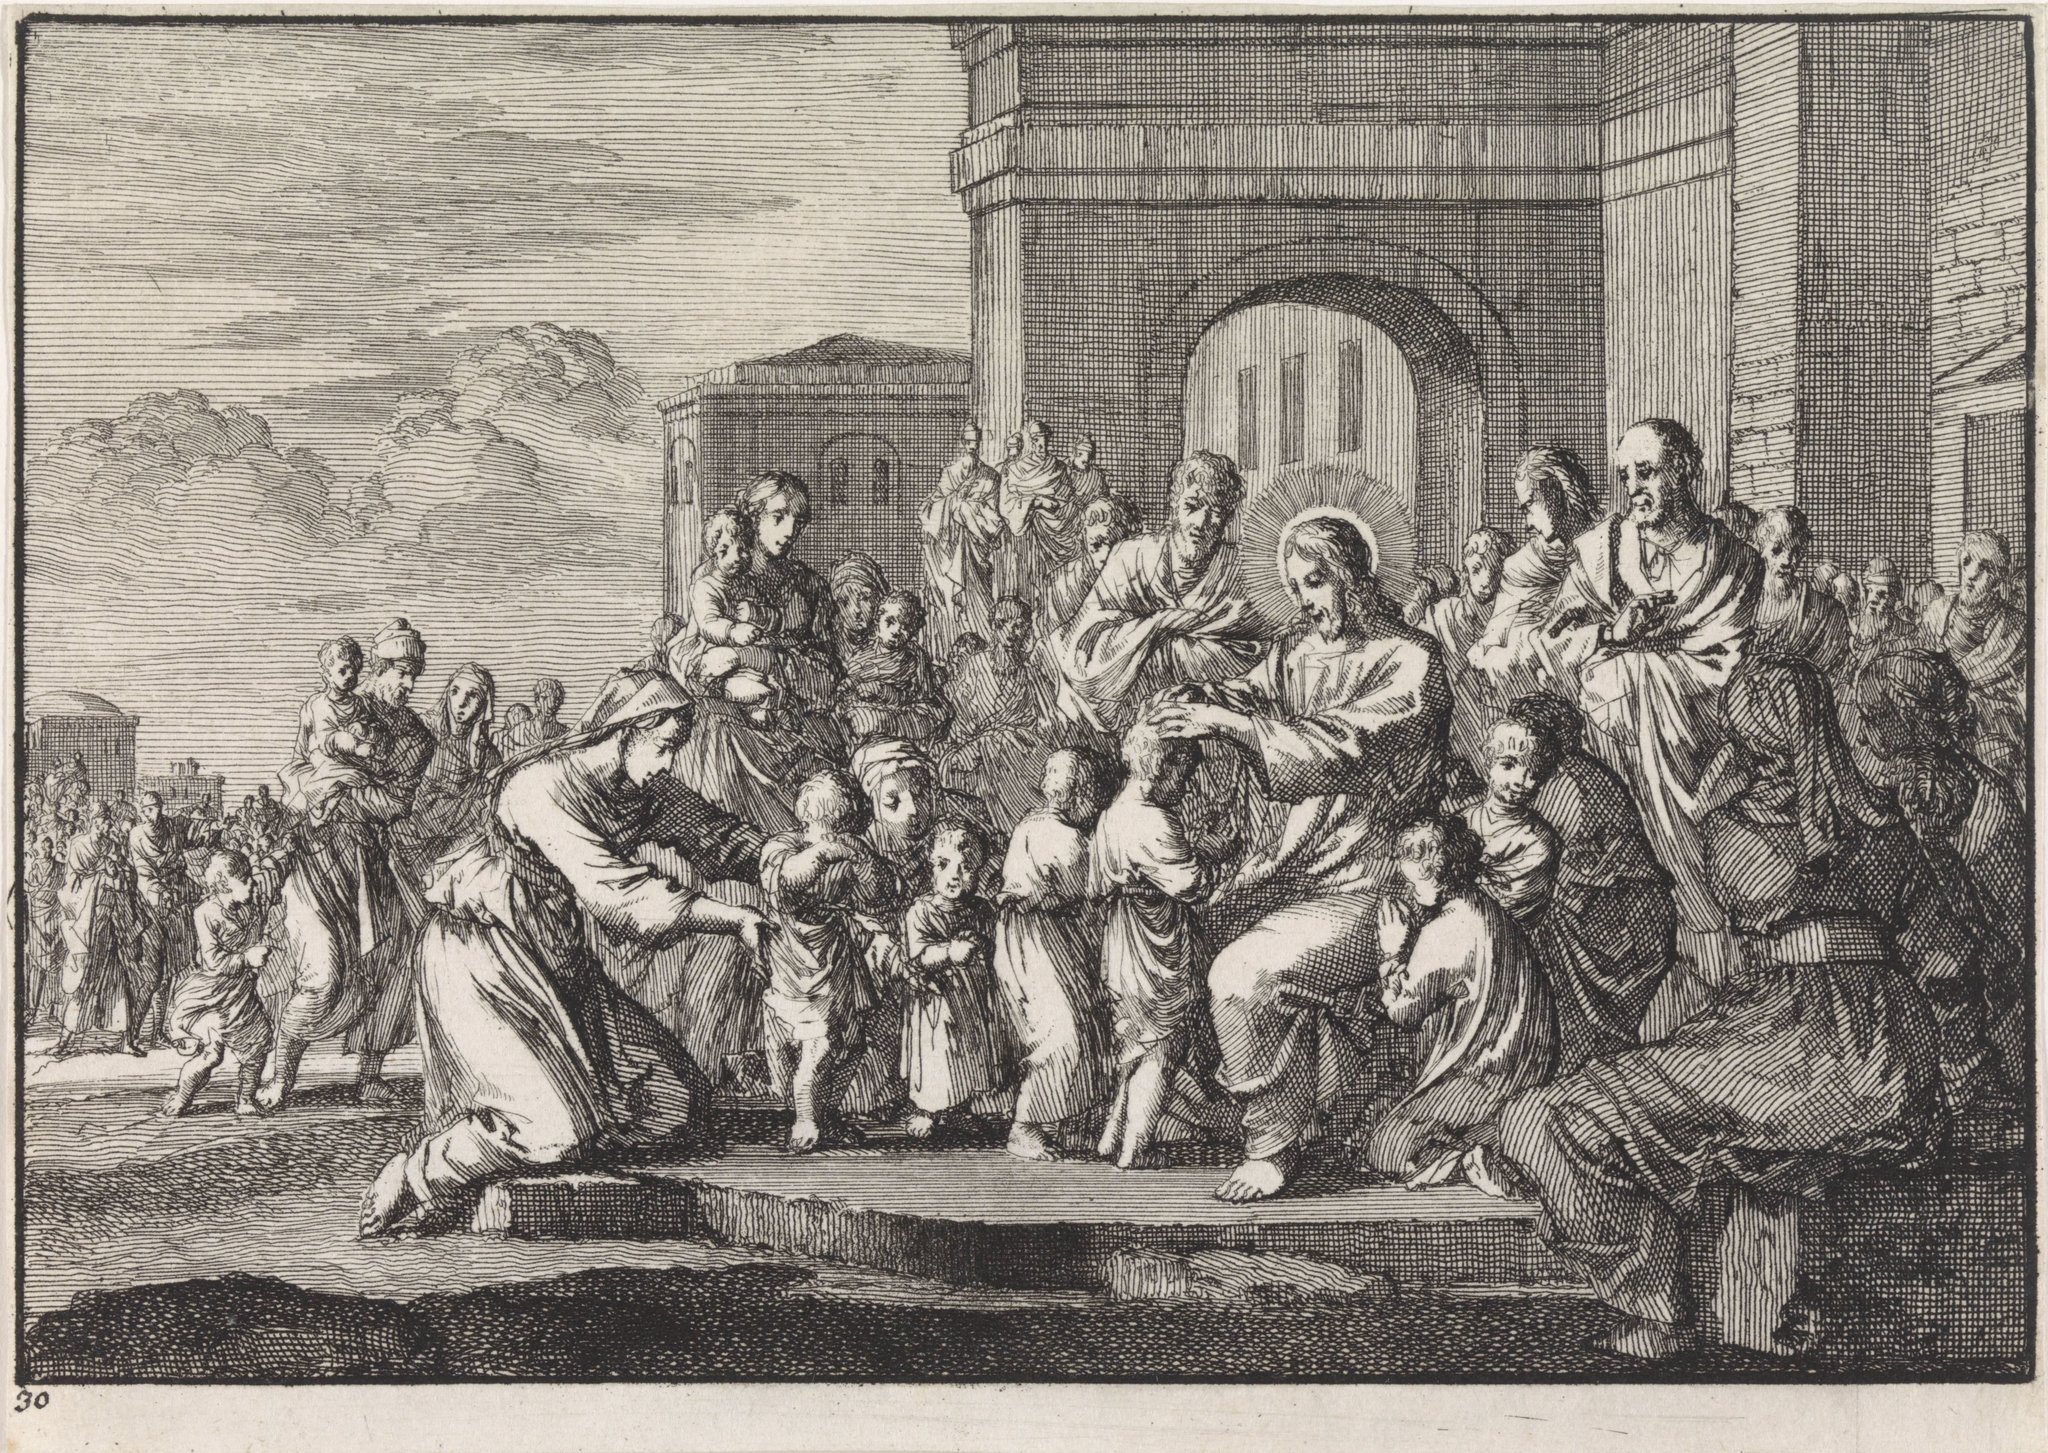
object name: print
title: Christus zegent de kinderen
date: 1703-1713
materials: paper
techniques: etching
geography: haarlem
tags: christ blessing children brought by their mothers, usually with some disciples disapprovingly looking on (matthew 19:13-15; mark 10:13-16; luke 18:15-17)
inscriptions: collector's mark: Lugt 2228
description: Proefdruk van een boekillustratie voor David Martin. Historie des Ouden en Nieuwen Testaments. Amsterdam, Pieter Mortier, 1703. Deel II. De boekillustraties voor de Mortierbijbel hebben verschillende staten en kopieën, waarbij de chronologische volgorde moeilijk te achterhalen valt. Als boekillustraties werden ze bovendien herhaaldelijk opnieuw gebruikt voor andere boekwerken.